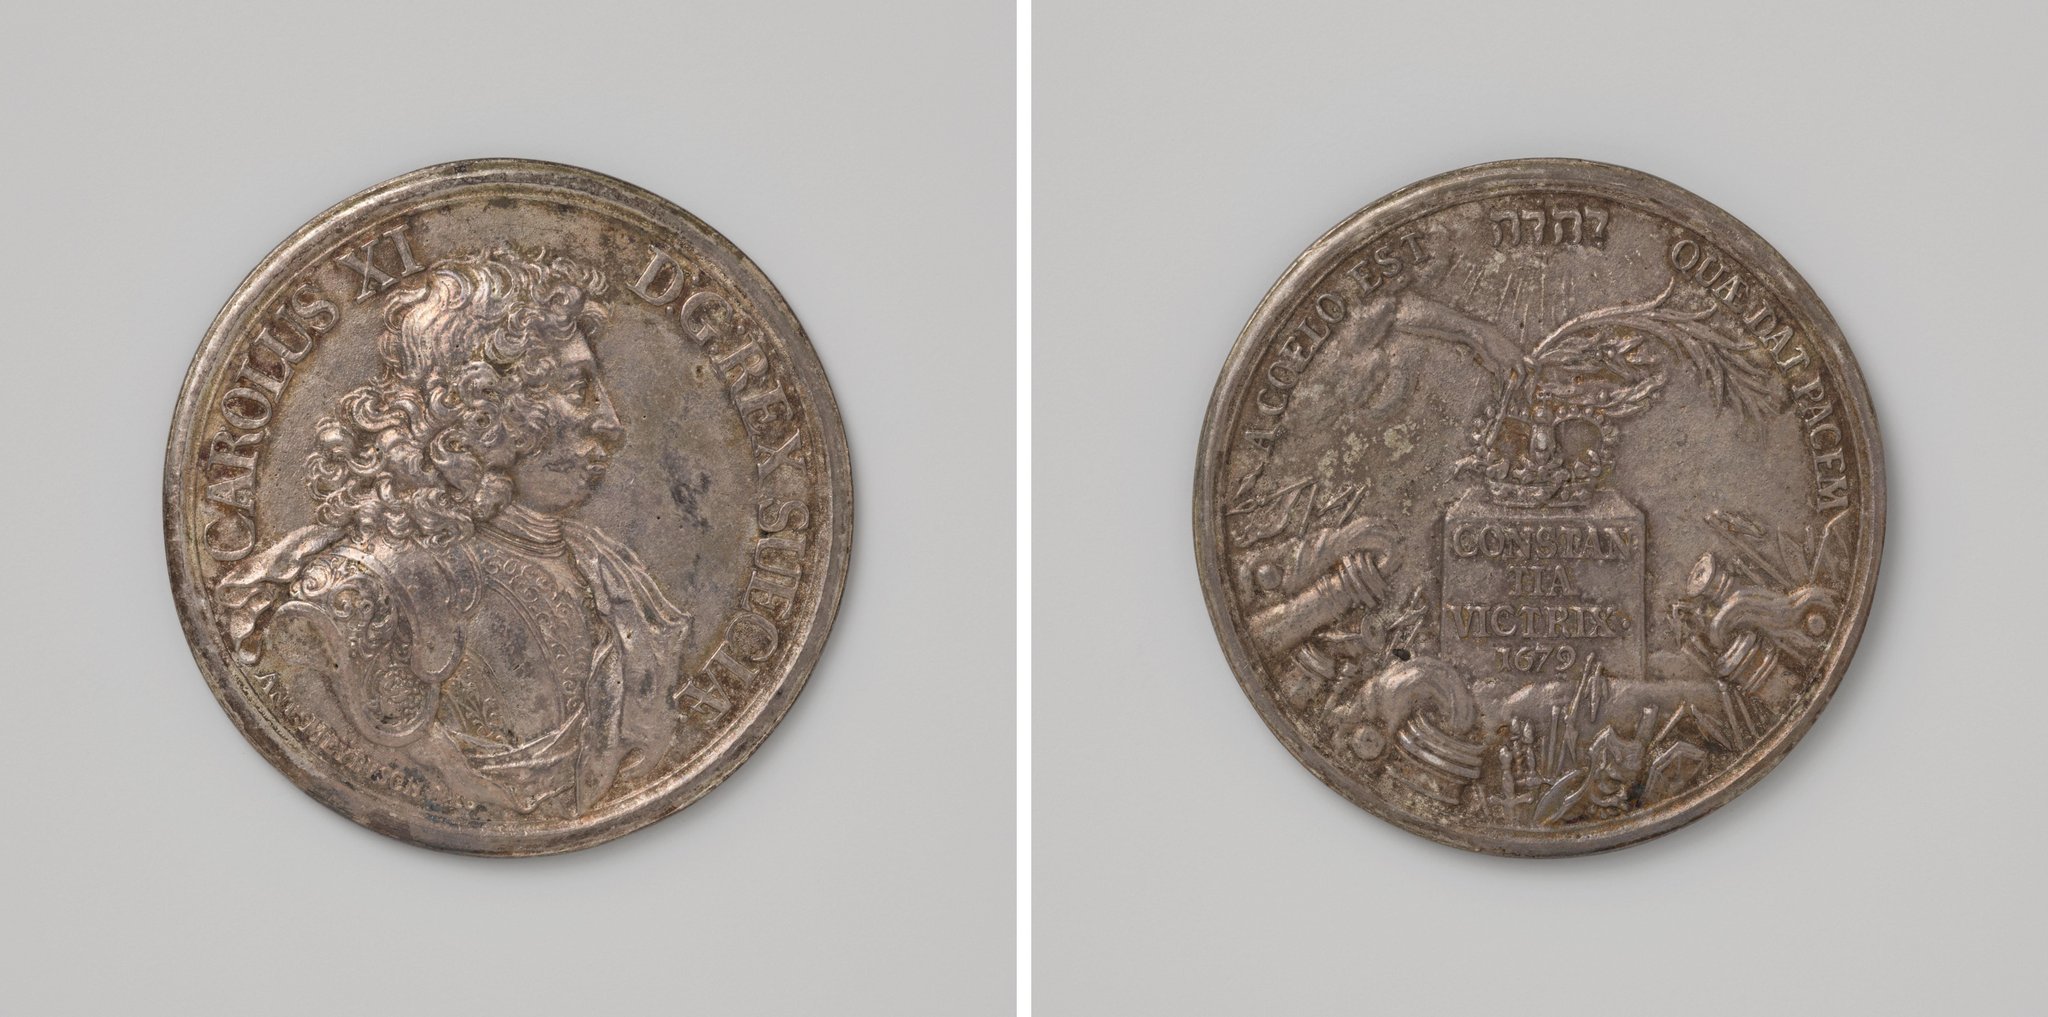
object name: history medal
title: Vrede van Fontainebleau tussen Denemarken en Zweden, ter ere van Karel XI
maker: anton meybusch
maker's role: medailleur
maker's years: 1645-1702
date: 1679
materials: silver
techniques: striking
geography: stockholm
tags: stockholm, koning, karel xi (koning van zweden), île-de-france, fontainebleau, vrede van fontainebleau (1679)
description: Zilveren penning. Voorzijde: borststuk man binnen omschrift. Keerzijde: hand uit wolken legt krans en vredestak op kroon die rust op vierkante steen temidden van wapentuig binnen omschrift.